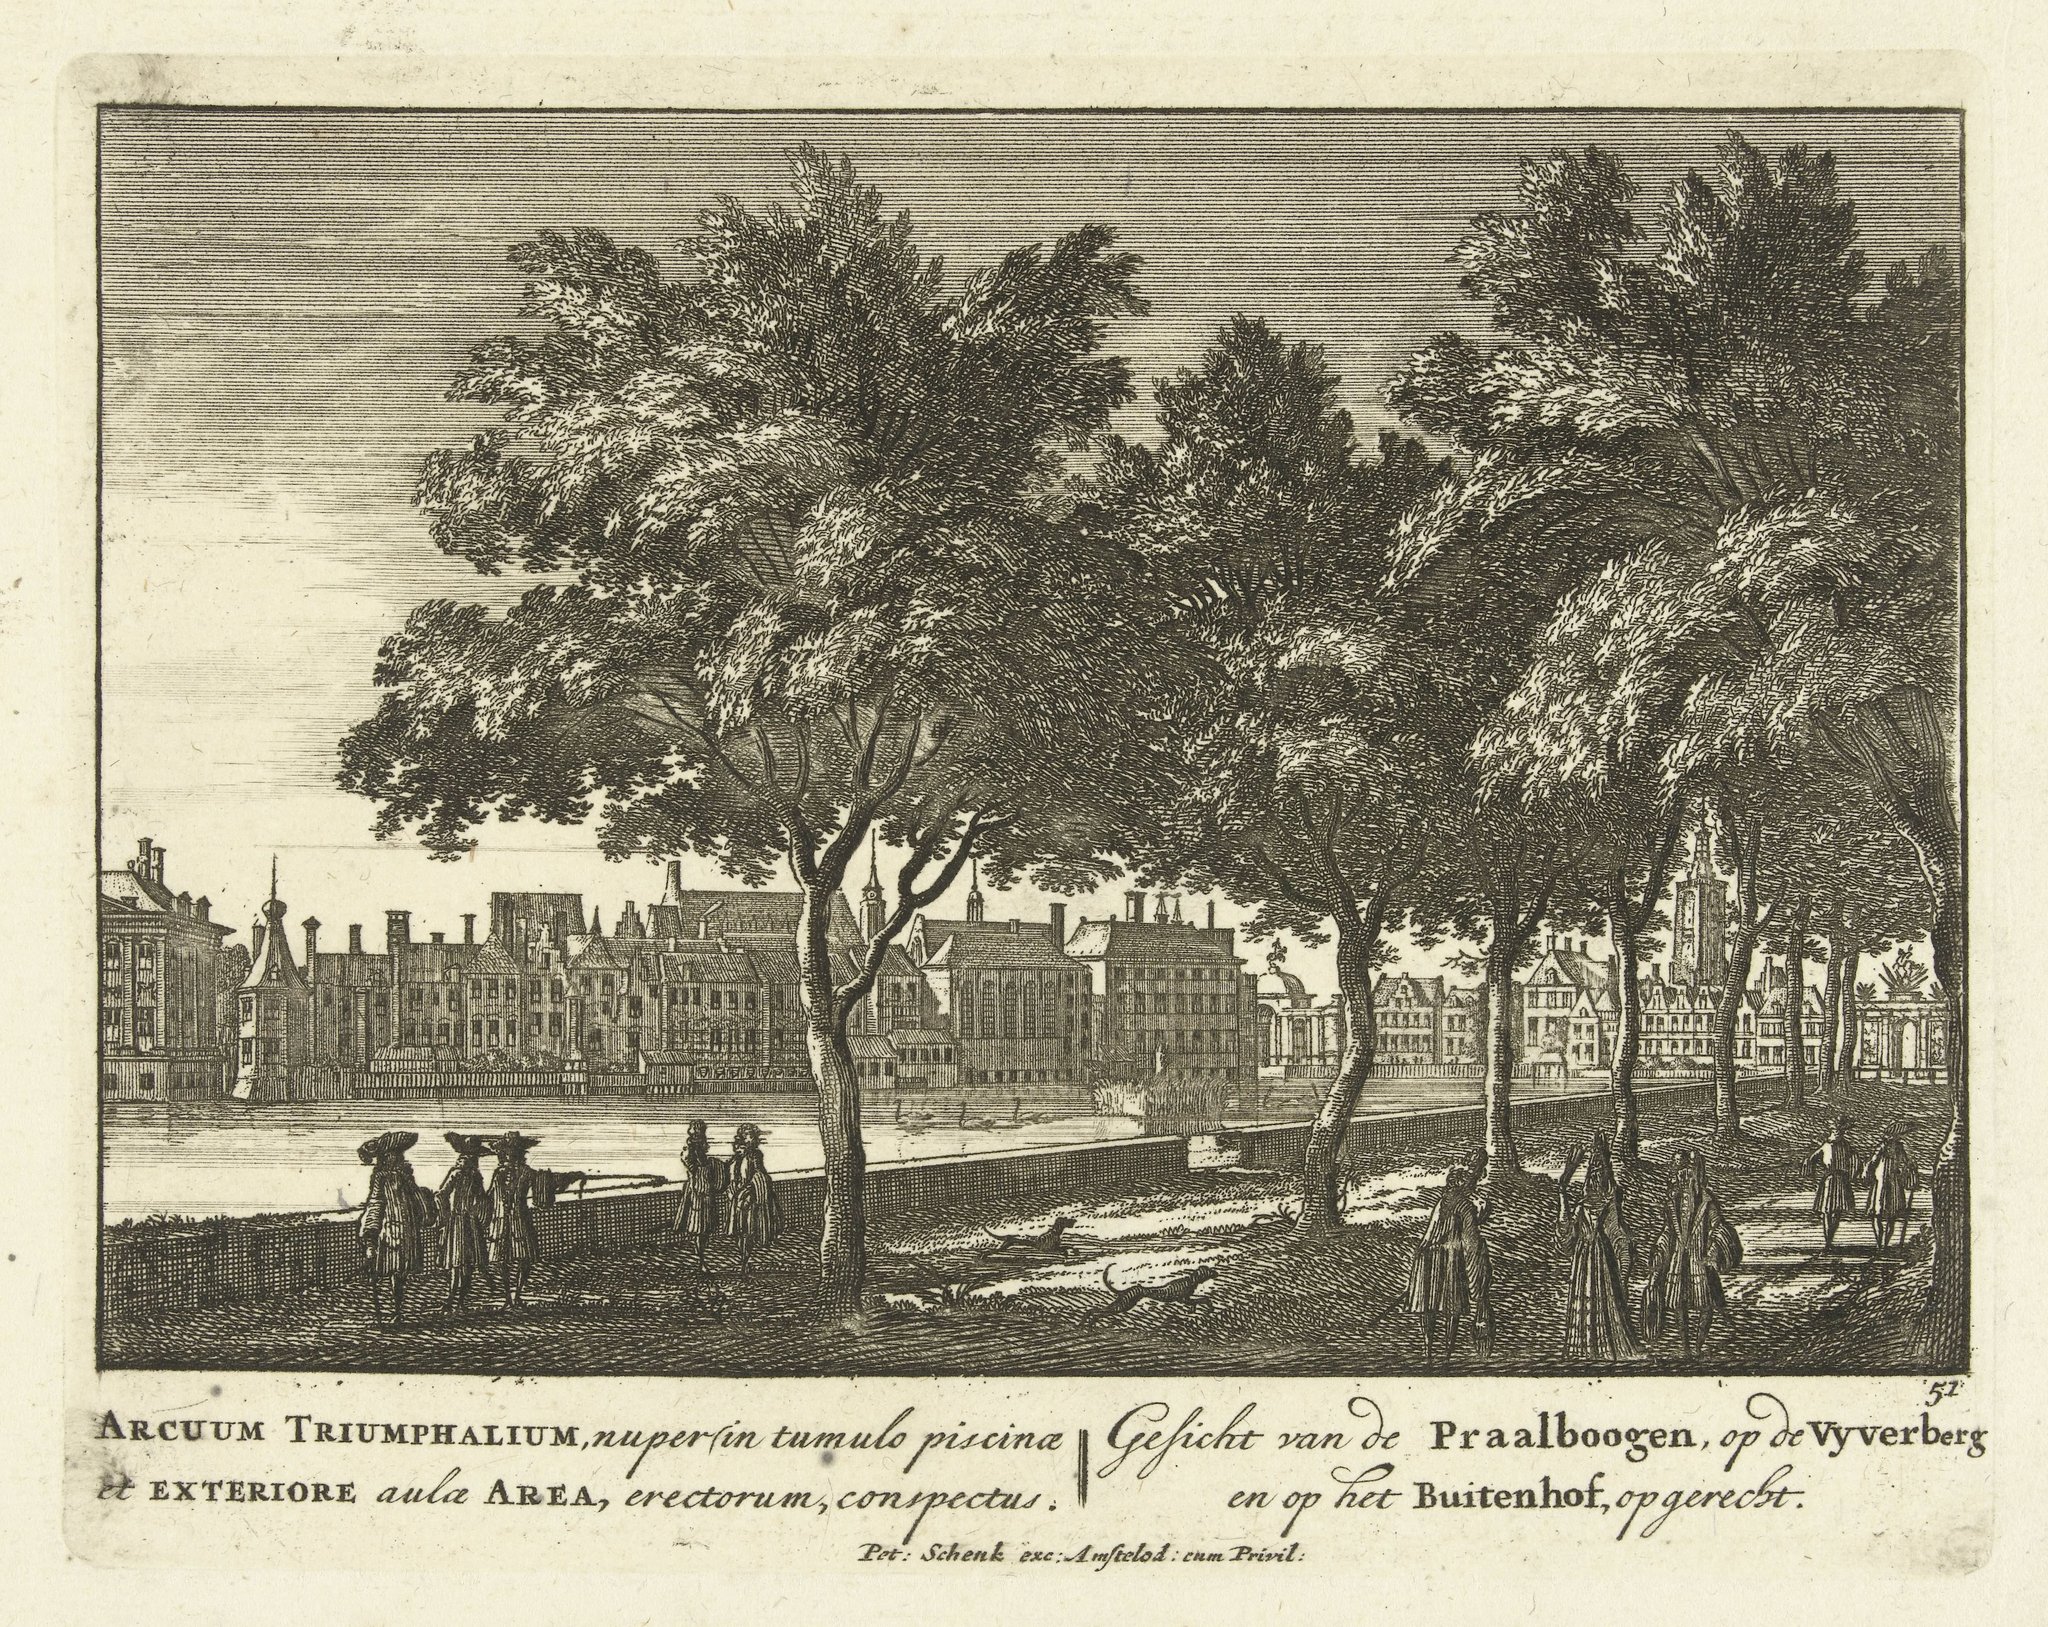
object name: print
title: Admirandorum quadruplex spectaculum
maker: pieter schenk (i)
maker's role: print maker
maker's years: 1660-1711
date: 1695-1705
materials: paper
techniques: etching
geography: amsterdam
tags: garden pond, village square, place, the hague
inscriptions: collector's mark: Lugt 2228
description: Prent uit een serie van 71 prenten met Rijnlandschappen, gezichten op vorstelijke paleizen en stadsgezichten uit Den Haag en Amsterdam.